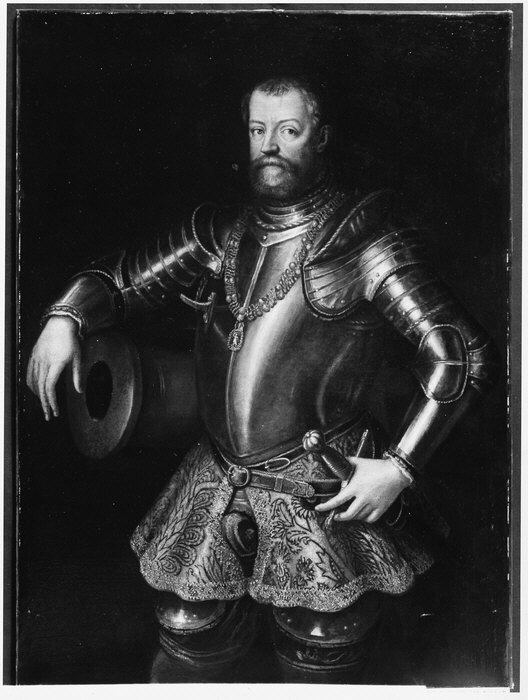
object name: painting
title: Alfonso I d'Este (1476–1534), Duke of Ferrara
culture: italian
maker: italian (ferrarese) painter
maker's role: artist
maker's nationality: italian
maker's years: 1400-1499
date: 1526-1550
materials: canvas, oil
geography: italy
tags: armor,men,portraits